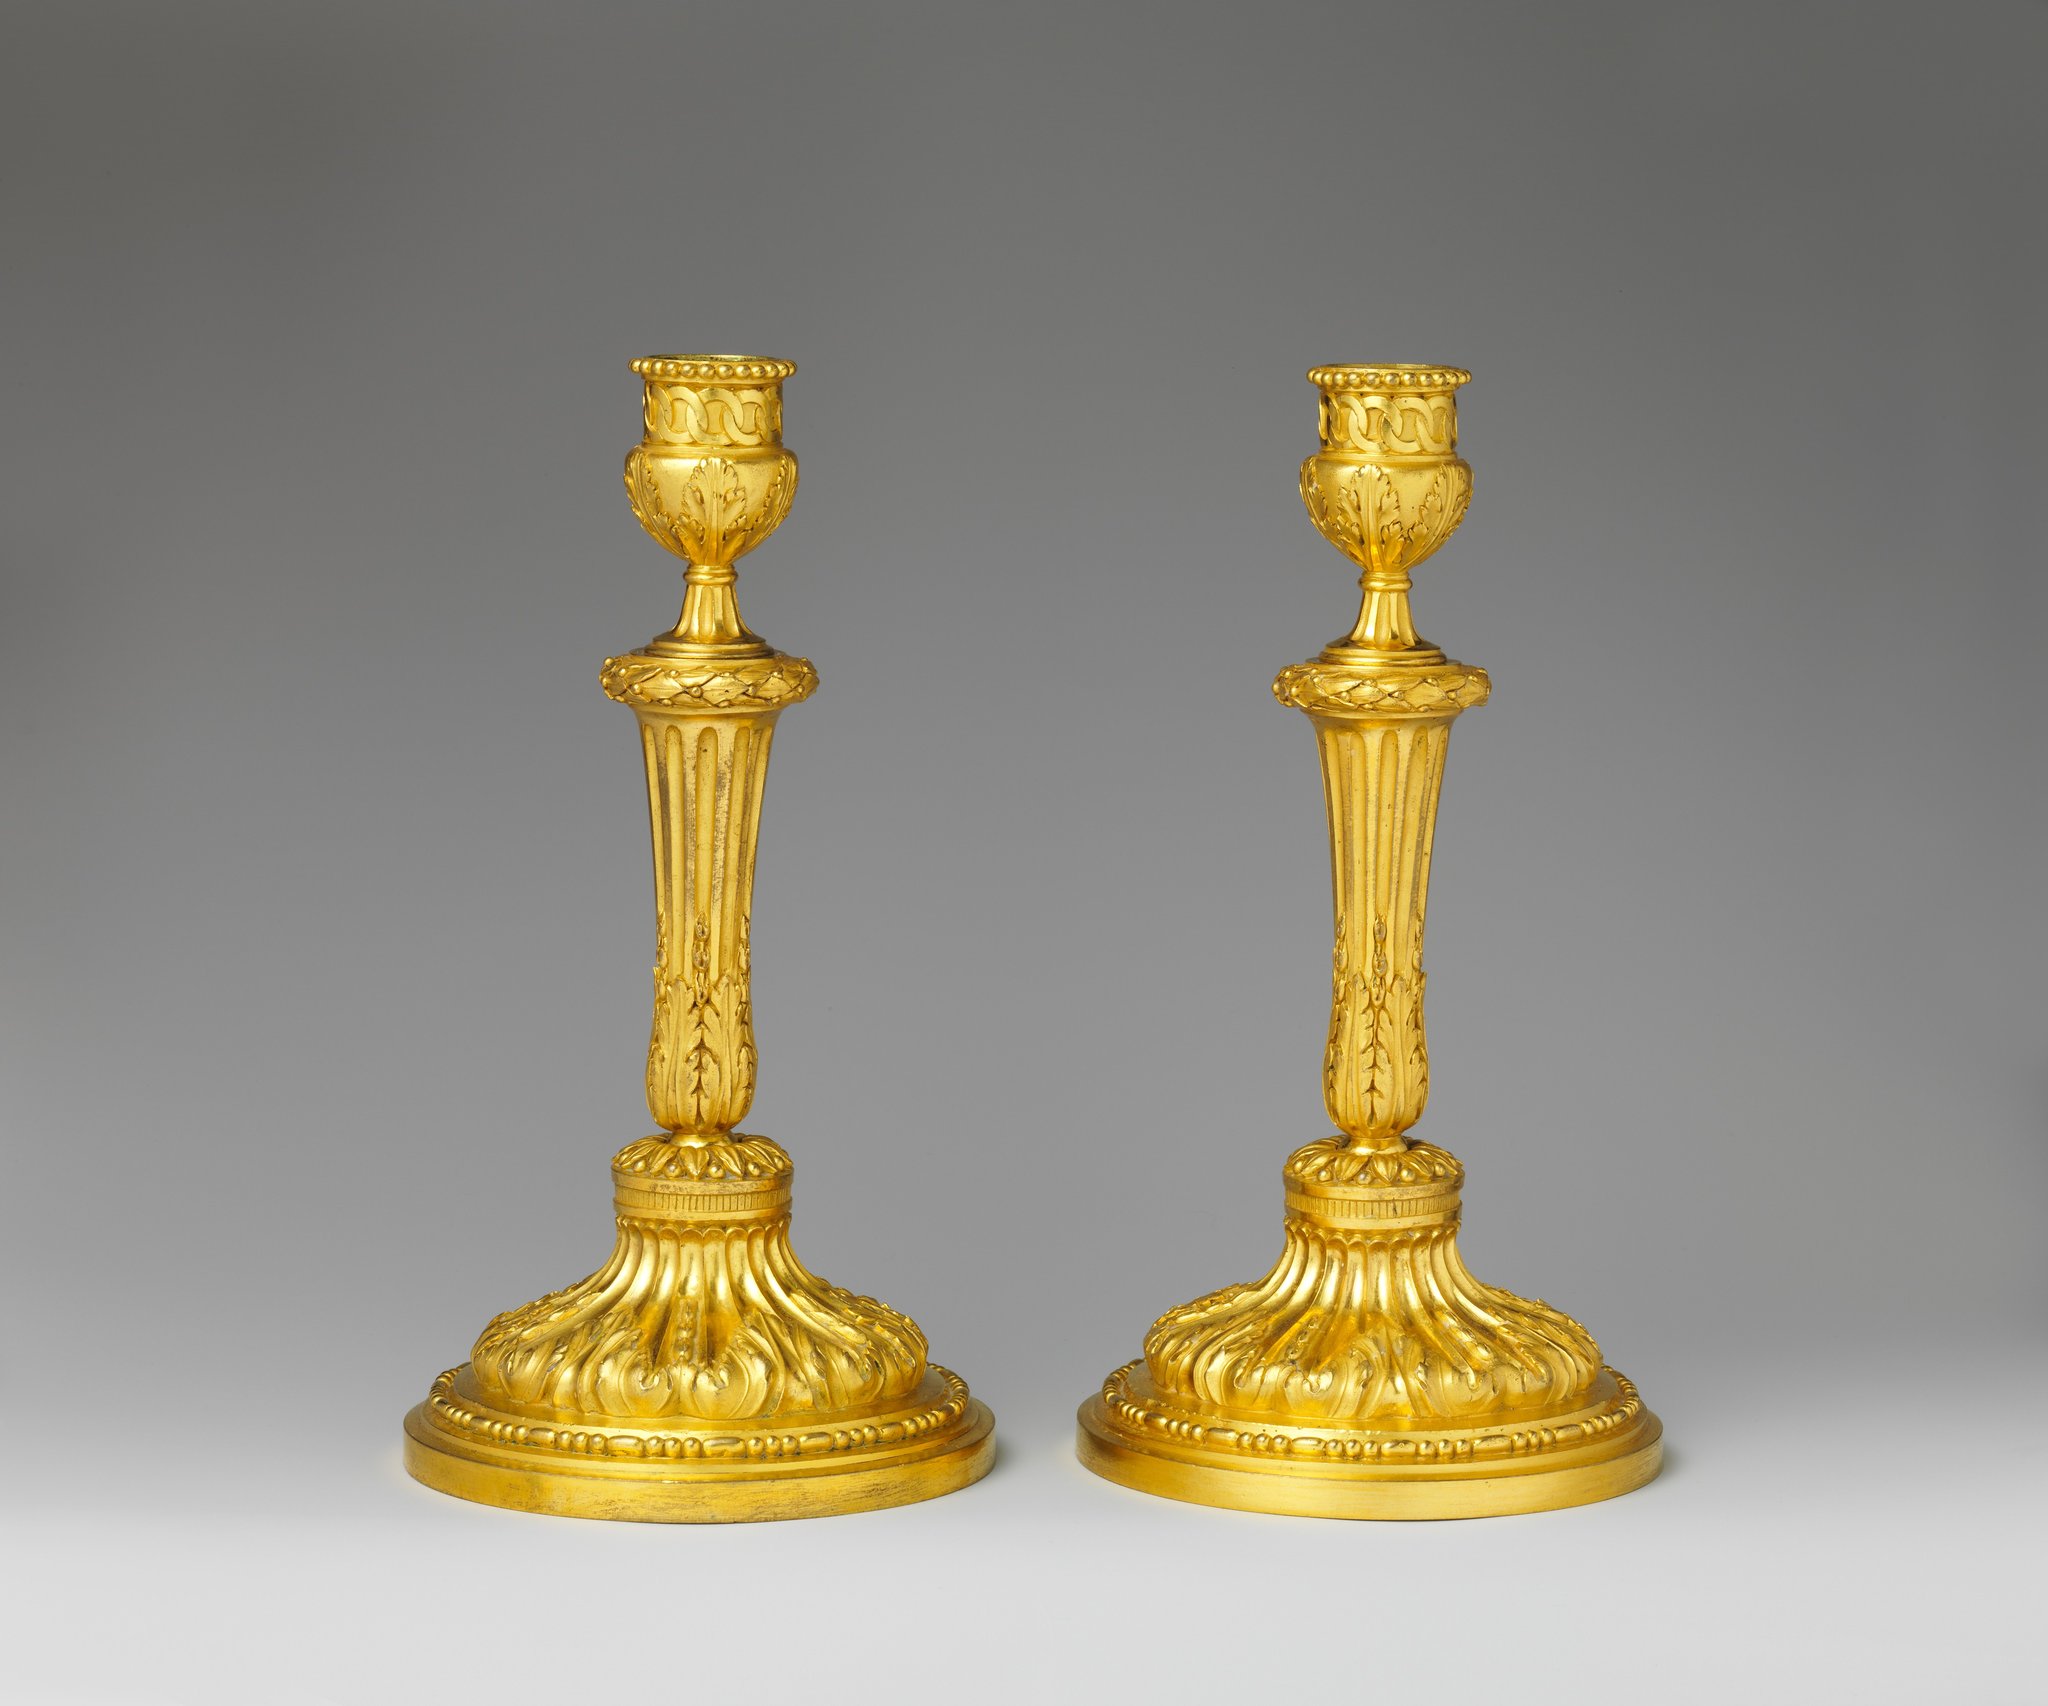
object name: candlestick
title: Pair of candlesticks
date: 1770-1775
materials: gilt bronze